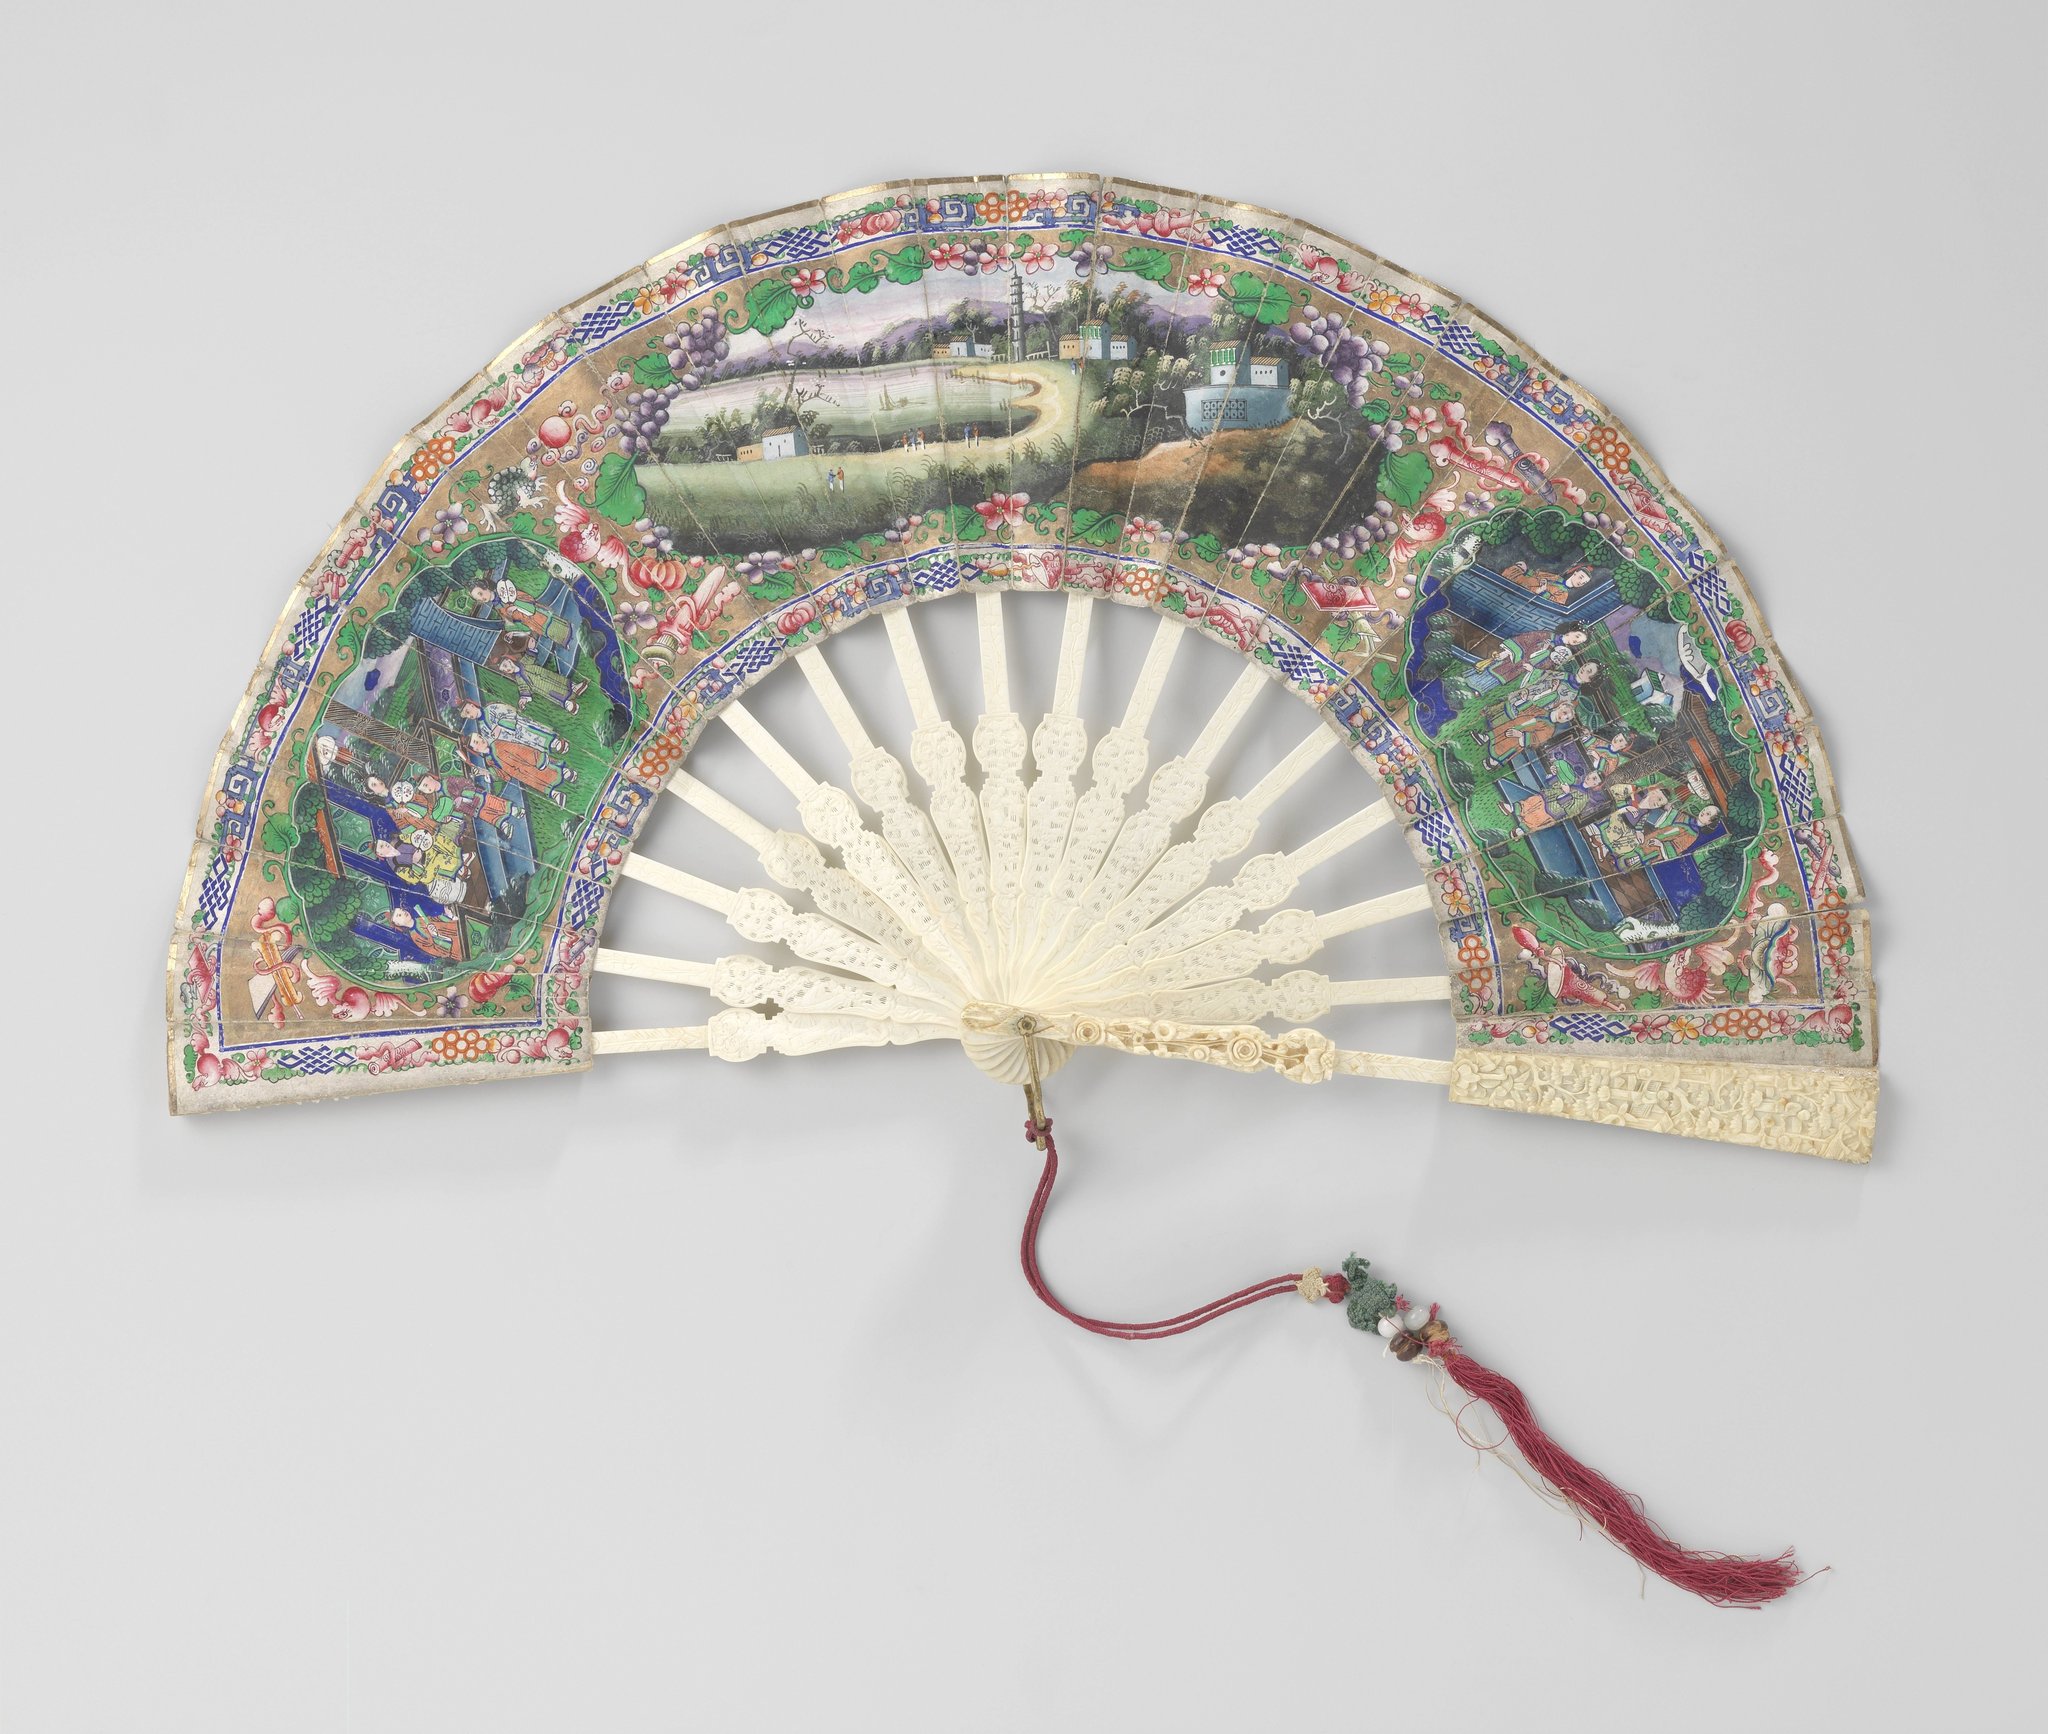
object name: vouwwaaier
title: Double-sided folding fan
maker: Anonymous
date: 1800-1825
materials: copper, paint, glass, gouache, ivory, paper, silk, wood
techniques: cutting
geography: guangdong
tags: chinese (+ other cultural aspects)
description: Fans decorated with figures, whose faces were made of painted ivory and their clothing of silk, were produced in southern China as early as the 17th century. Over the course of the 18th century, this type of fan developed further in Canton and also became extremely popular in Europe. Depicted on this fan are Taoist figures with their attributes; they are ‘Immortals’, seated on clouds.